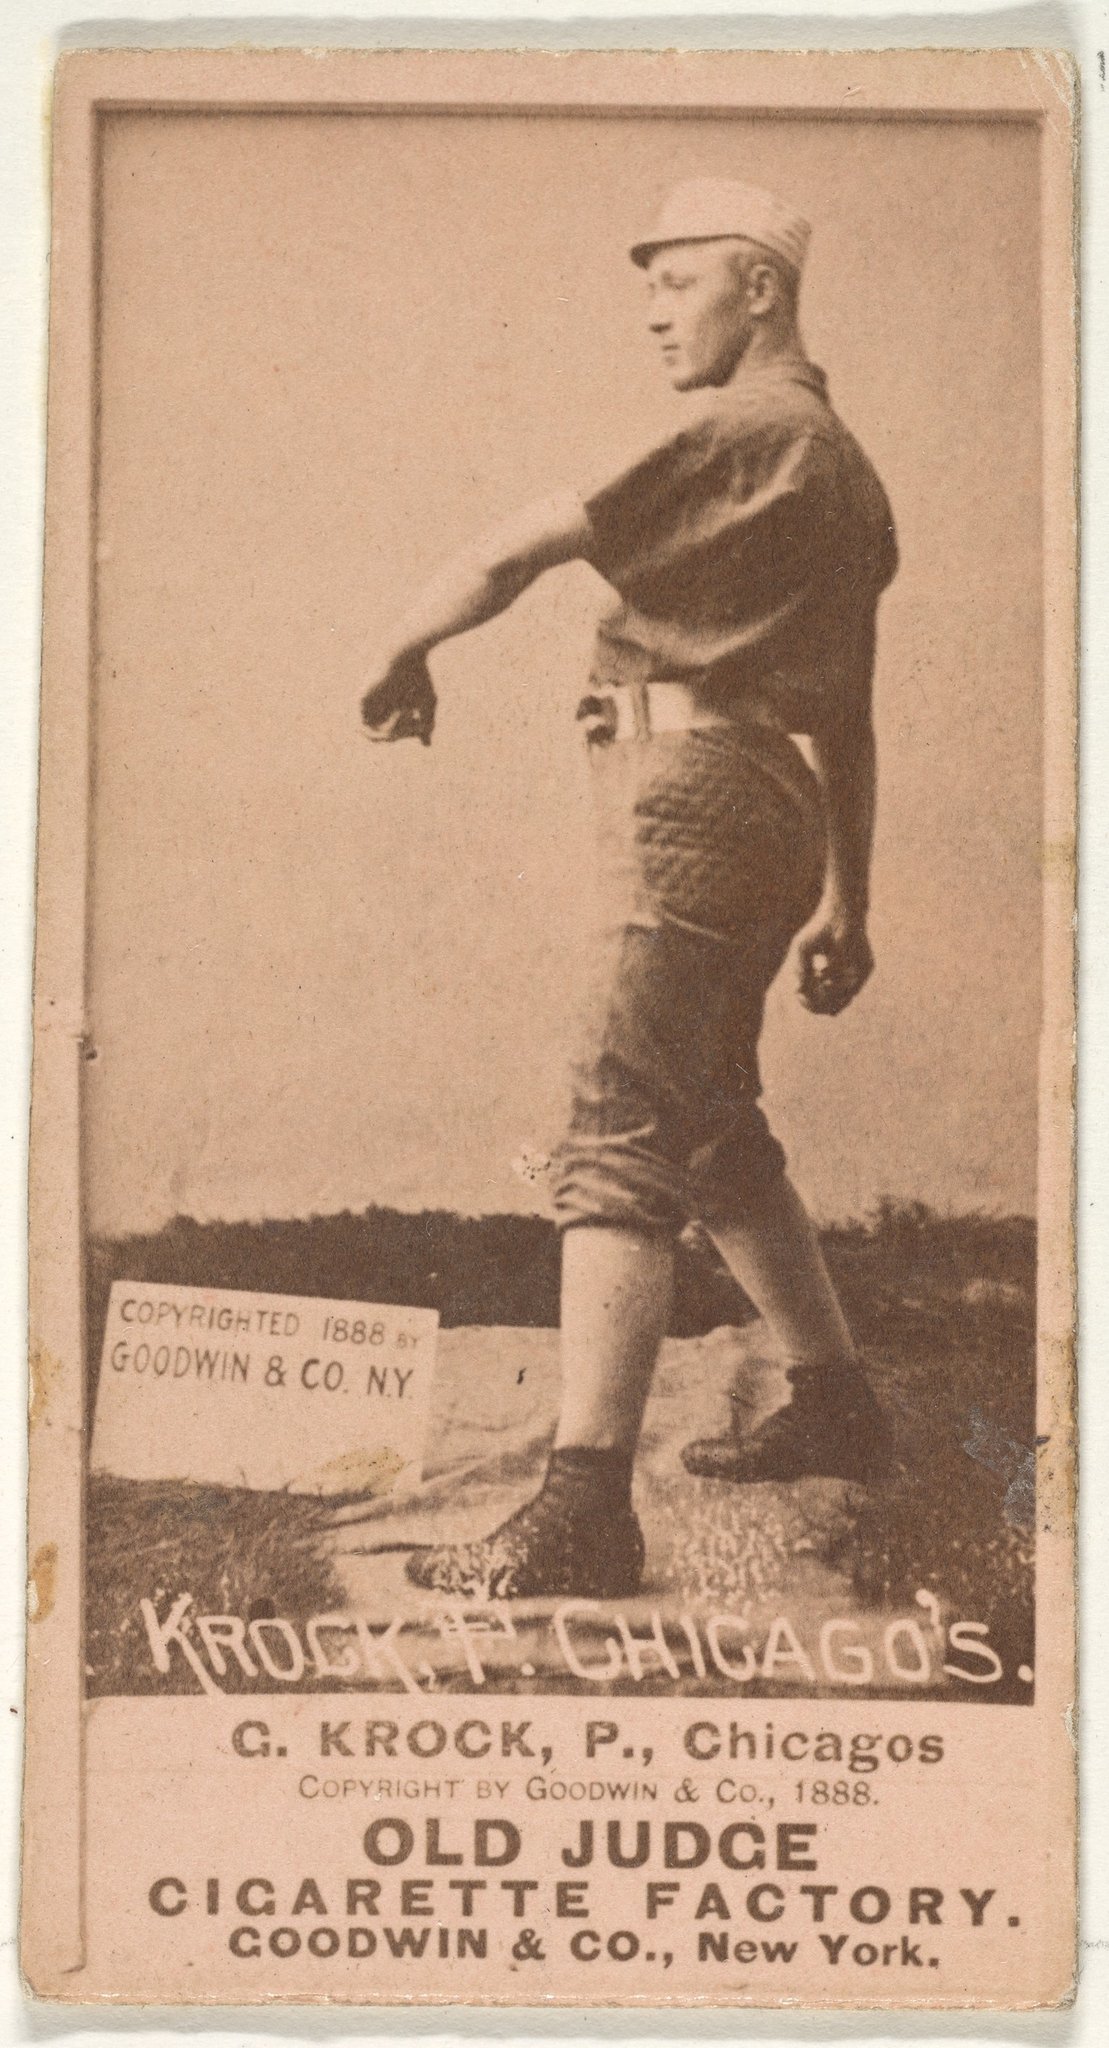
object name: baseball card, photograph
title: August H. "Gus" Krock, Pitcher, Chicago, from the Old Judge series (N172) for Old Judge Cigarettes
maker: goodwin & company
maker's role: publisher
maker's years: 1850-1950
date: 1888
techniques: albumen silver print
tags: men,baseball,athletes